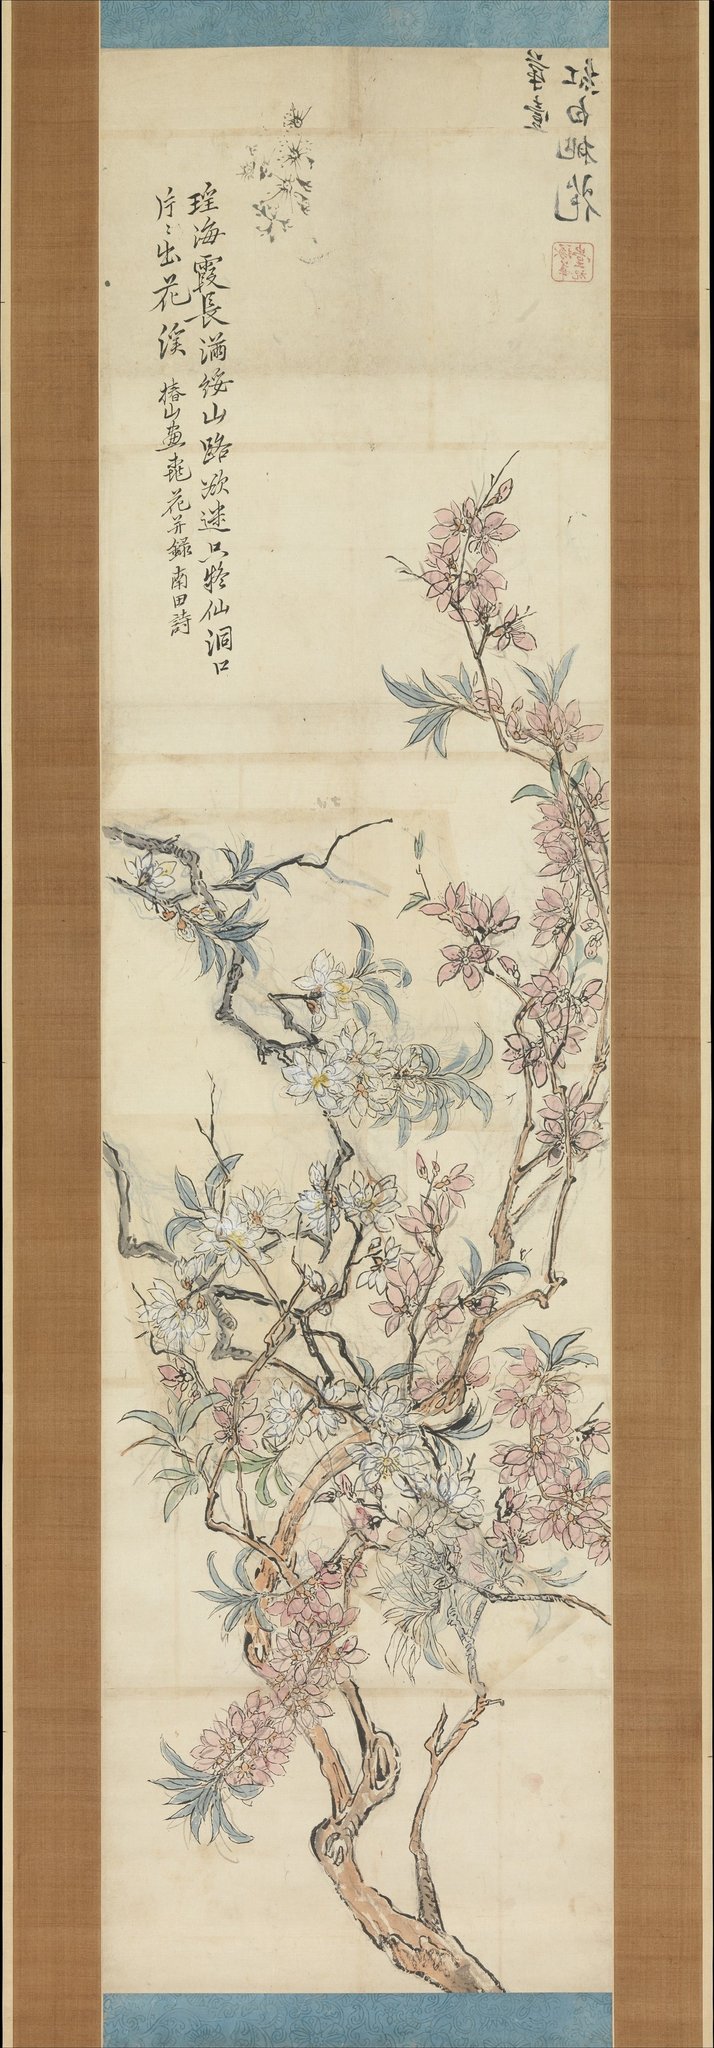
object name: hanging scroll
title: Red and White Peach Blossoms, Preparatory Sketch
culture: japanese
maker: tsubaki chinzan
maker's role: artist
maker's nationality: japanese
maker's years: 1801-1854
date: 1843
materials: paper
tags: flowers